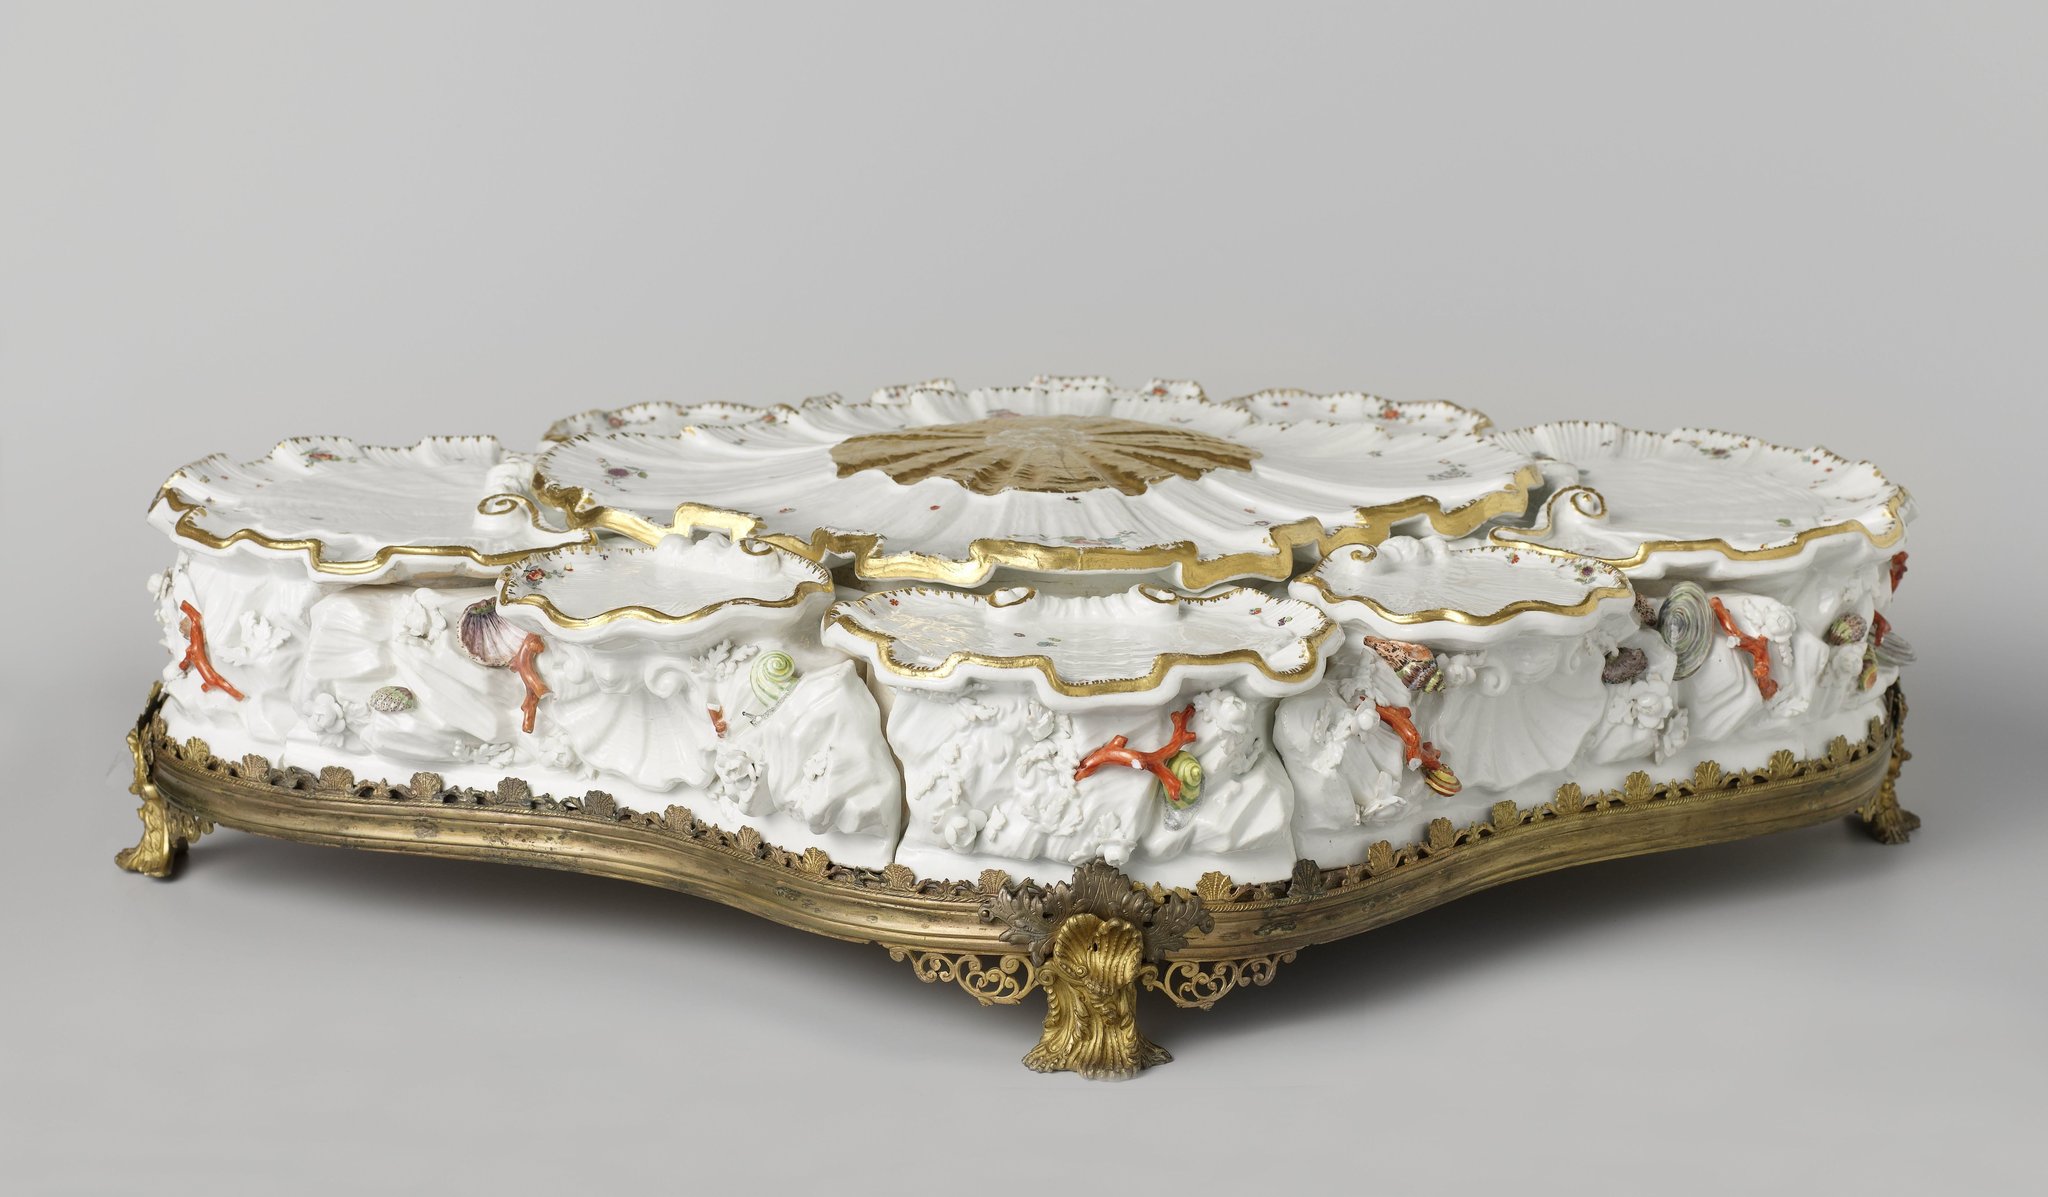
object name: pedestal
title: Parts of a Service, Known as the ‘Swan Service’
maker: johann joachim kändler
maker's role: designer, sculptor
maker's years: 1706-1775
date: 1738-1739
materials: metal, porcelain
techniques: gilding, painted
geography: meissen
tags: heinrich von brühl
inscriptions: mark, factory mark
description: These pieces are part of one of the most famous services produced by the Meissen Porcelain Factory. It was ordered by Count Heinrich von Brühl, a statesman and the factory’s director. Scenes of swans occur on almost every one of the more than 2200 parts. On display are a dish, a sauceboat, and the base of the plat-de-ménage (centrepiece). The large basket decorated with figures that stood on it has been lost.